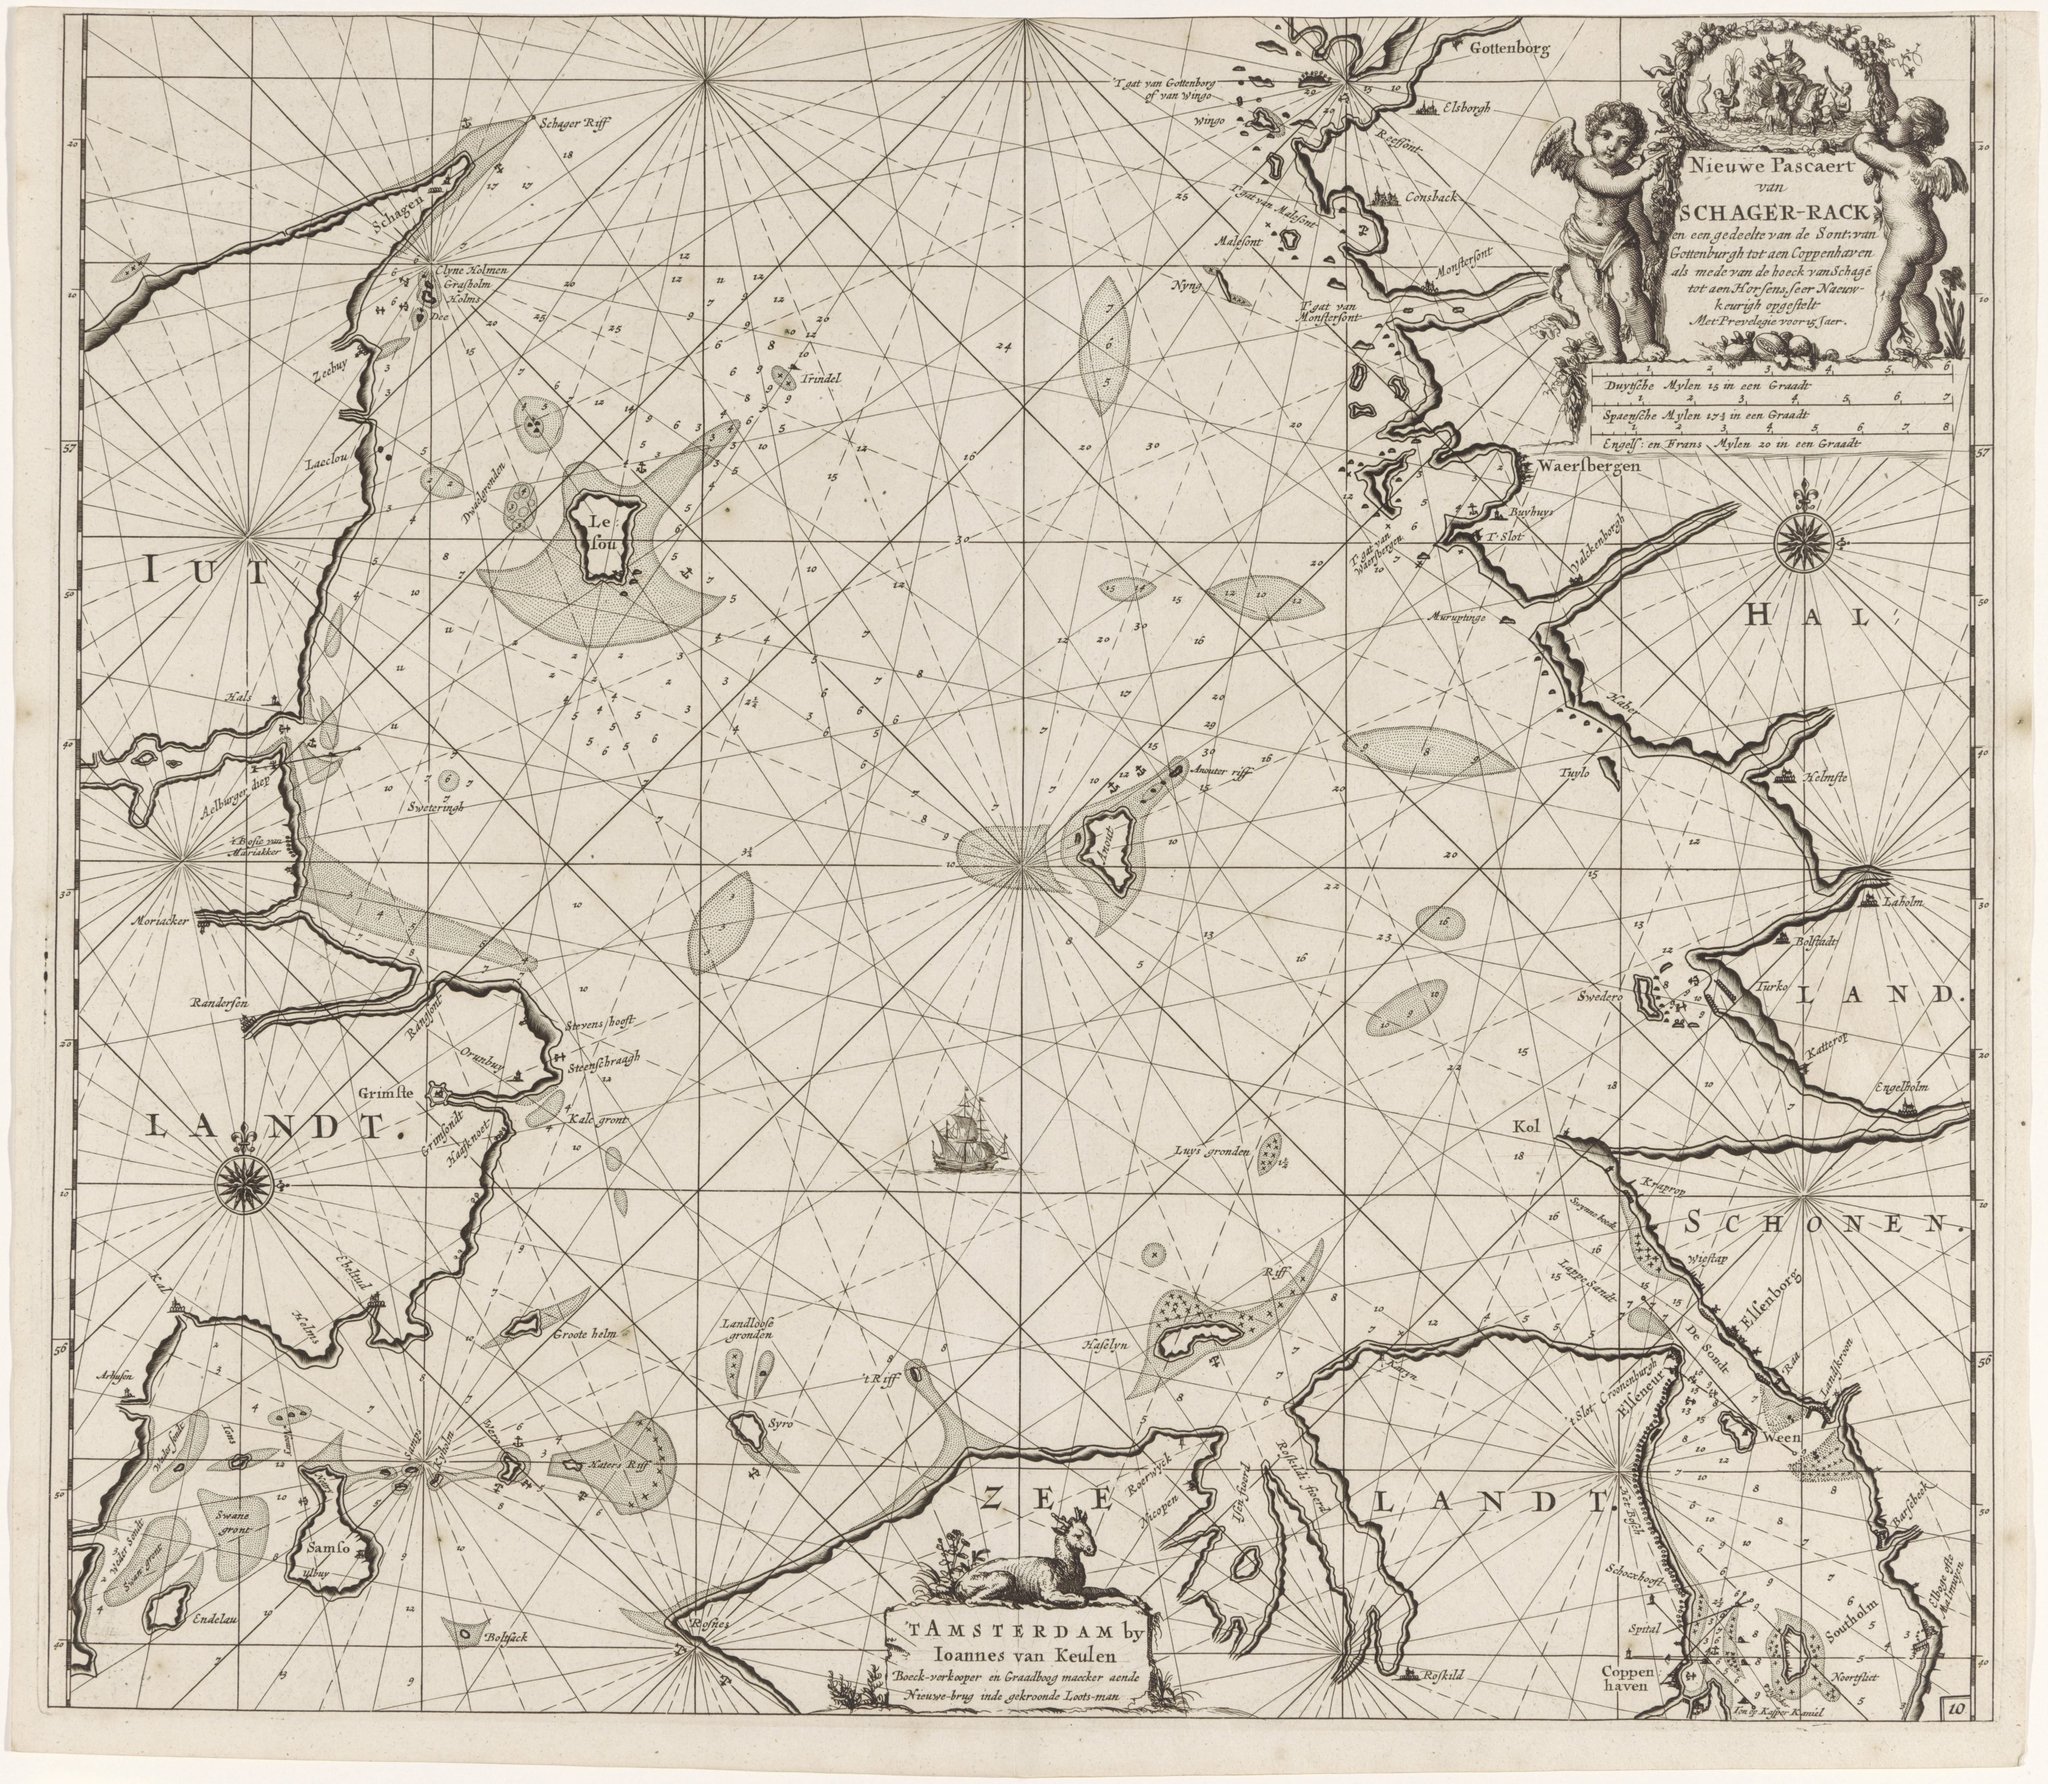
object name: print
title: Paskaart van Denemarken met het Skagerrak en het Kattegat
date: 1681-1799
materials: paper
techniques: engraving, etching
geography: amsterdam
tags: (story of) neptune (poseidon), goat, cupids: 'amores', 'amoretti', 'putti'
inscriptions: collector's mark: Lugt 2228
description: Paskaart van Denemarken met het Skagerrak en het Kattegat, met een kompasroos, het Noorden ligt boven. Rechtsboven een cartouche met de titel, geflankeerd door twee putti die een ingelijste afbeelding van Neptunus op zijn wagen omhoog houden. Onder de putti de schaal in Duitse, Spaanse en Engelse of Franse mijlen. Middenonder het uitgeversadres op een steen, waarop een bok ligt.